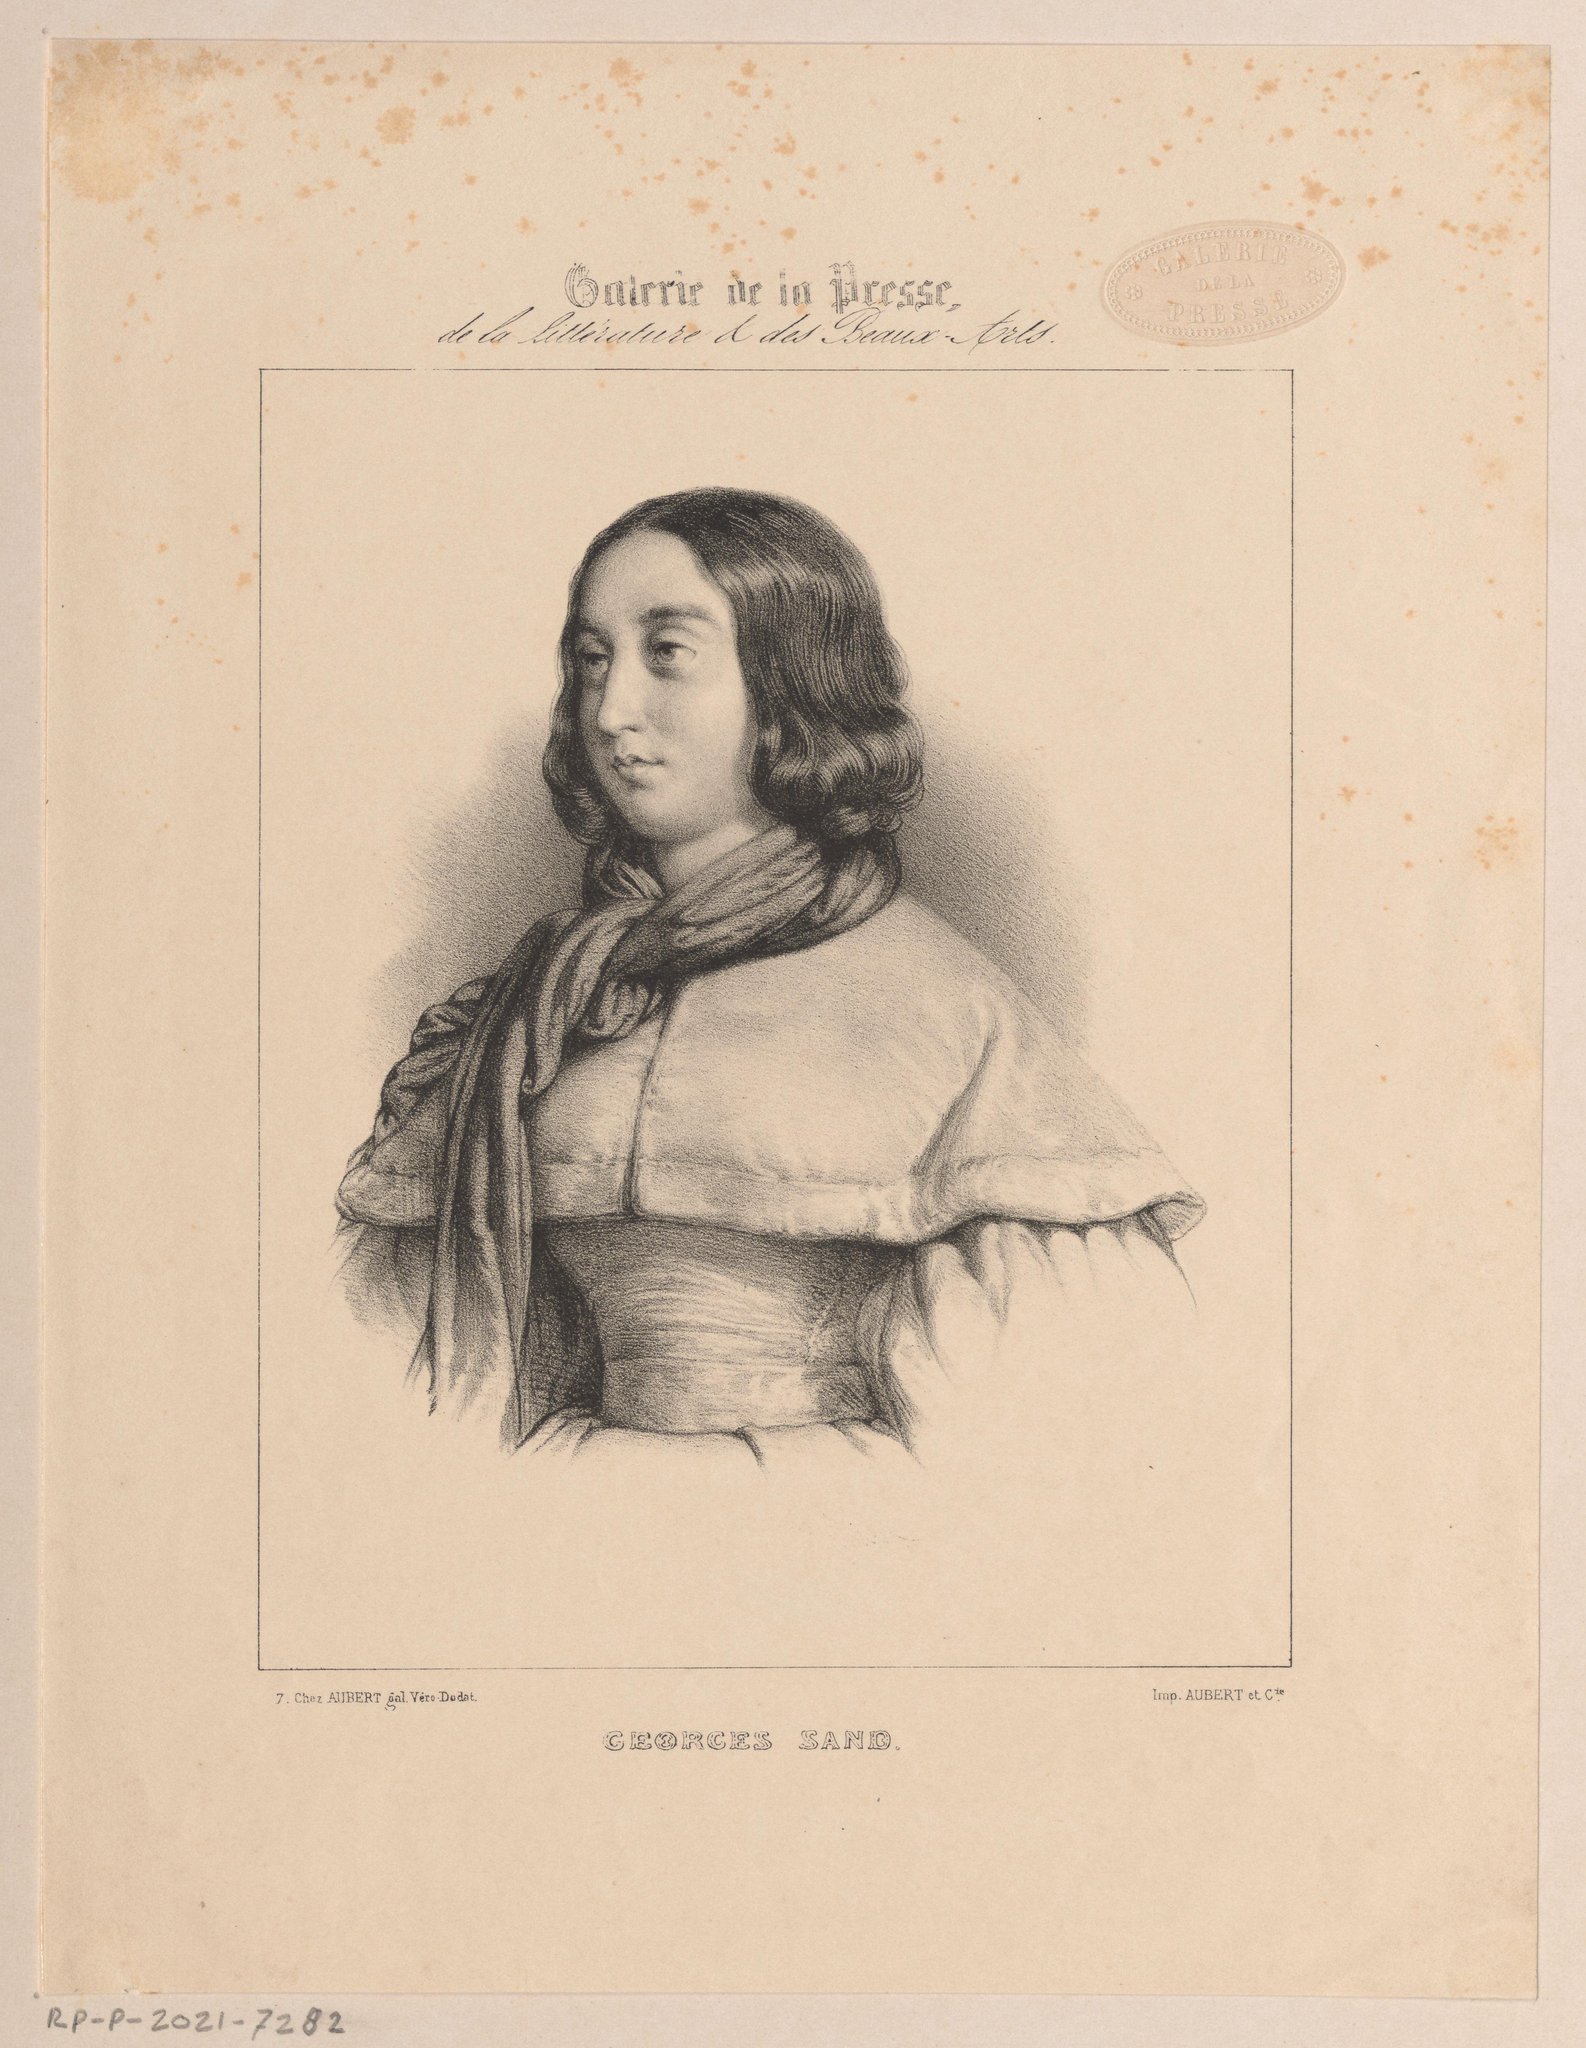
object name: print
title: Galerie de la presse, de la littérature et des beaux-arts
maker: Anonymous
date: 1836-1841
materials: paper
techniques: lithograph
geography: paris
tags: paris, george sand, historical persons, portrait of a writer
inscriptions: collector's mark: Lugt 2228, check stamp: Lugt 4904